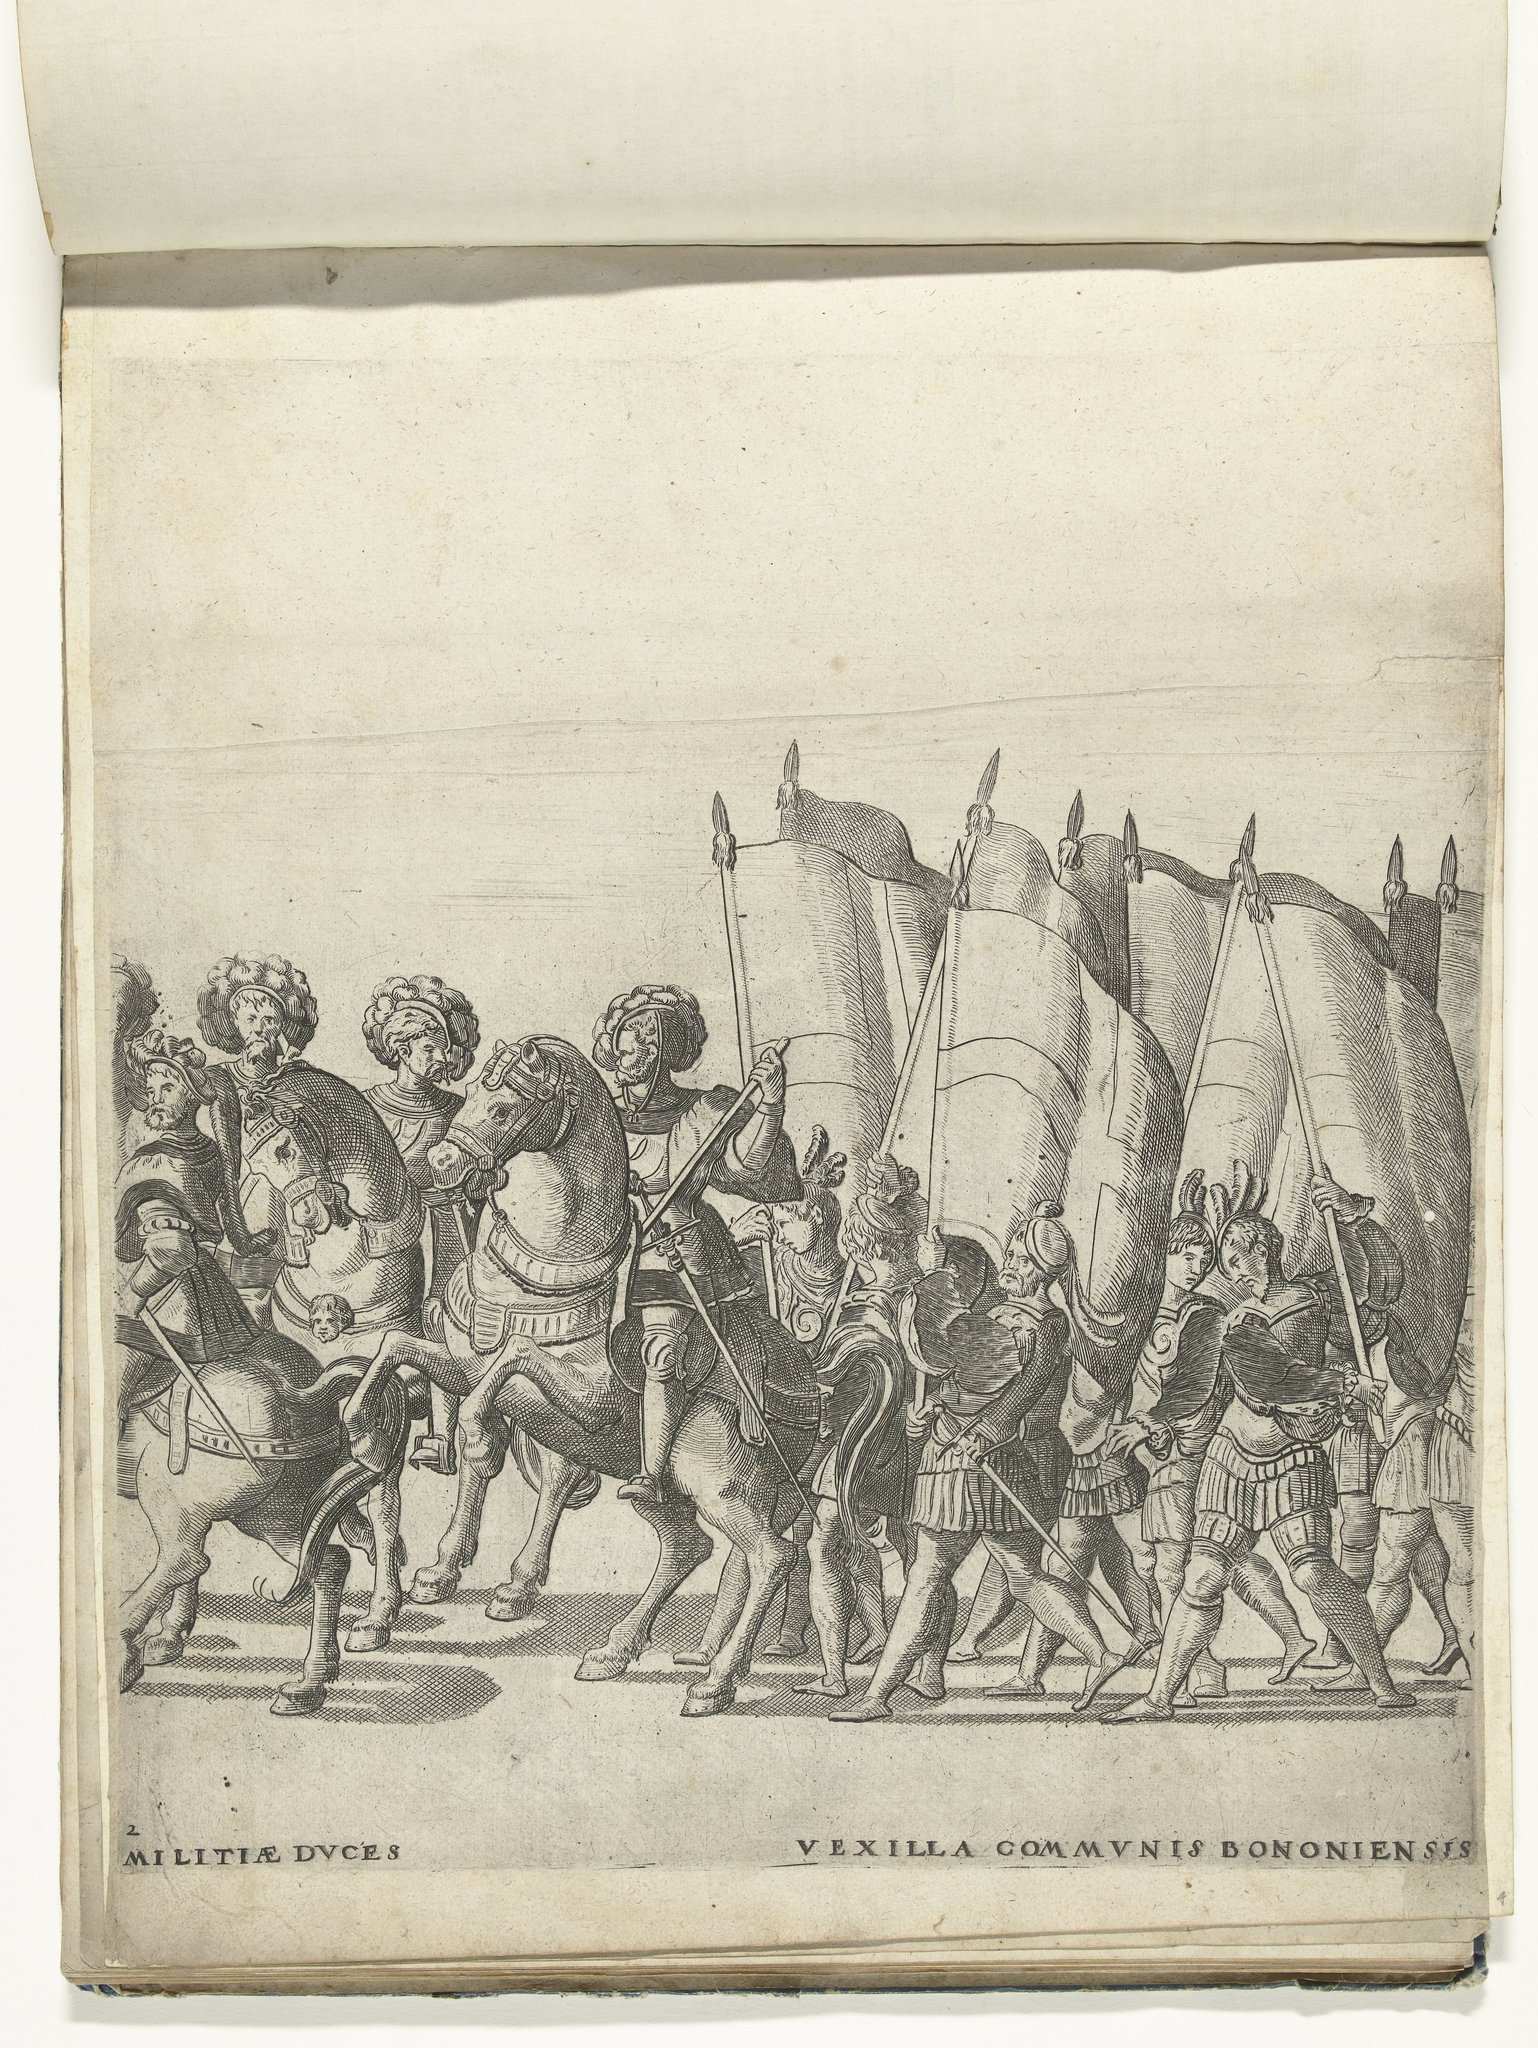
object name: propagandaprent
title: Optocht van Karel V met de paus te Bologna na zijn kroning to keizer, 1530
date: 1530-1536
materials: paper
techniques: engraving, etching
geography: mechelen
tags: charles v (holy roman emperor and king of spain), festivities (+ parade, pageant, cavalcade ~ festive activities)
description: Prent in het album waarin zijn ingeplakt de 40 platen die achterelkaar samen het fries vormen van de optocht van Karel V met de paus Clemens VII te Bologna na zijn kroning tot keizer, 24 februari 1530.